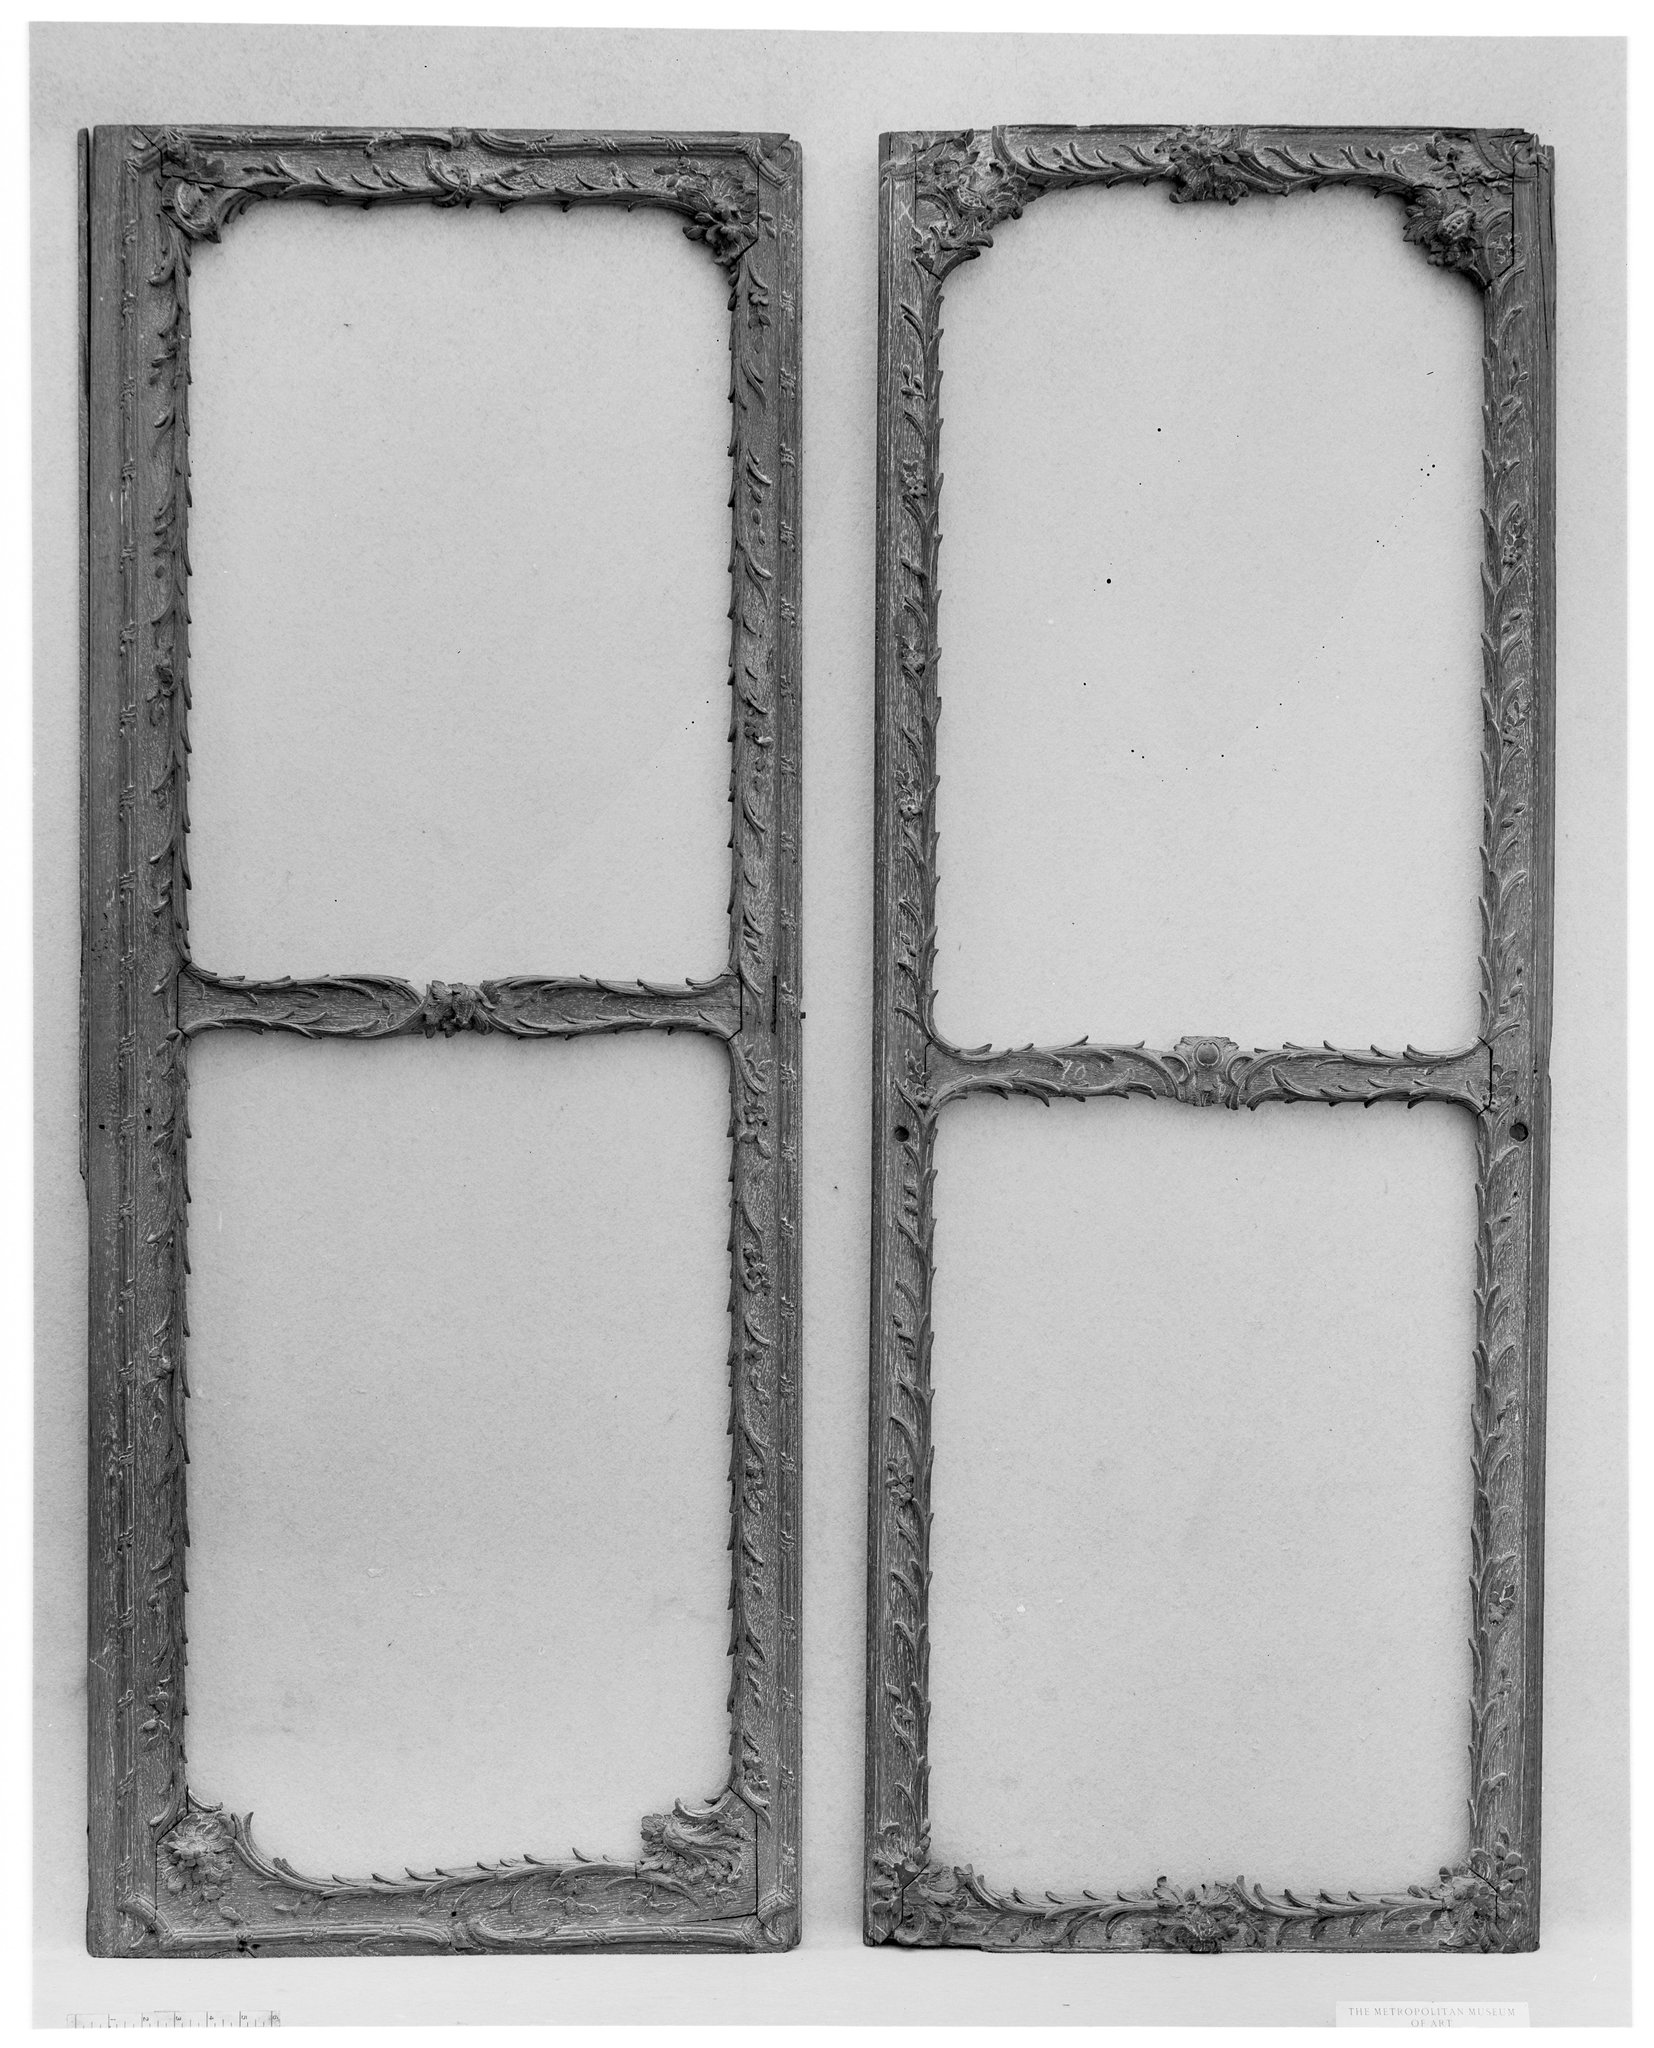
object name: bookcase door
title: Set of bookcase doors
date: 1701-1750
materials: wood